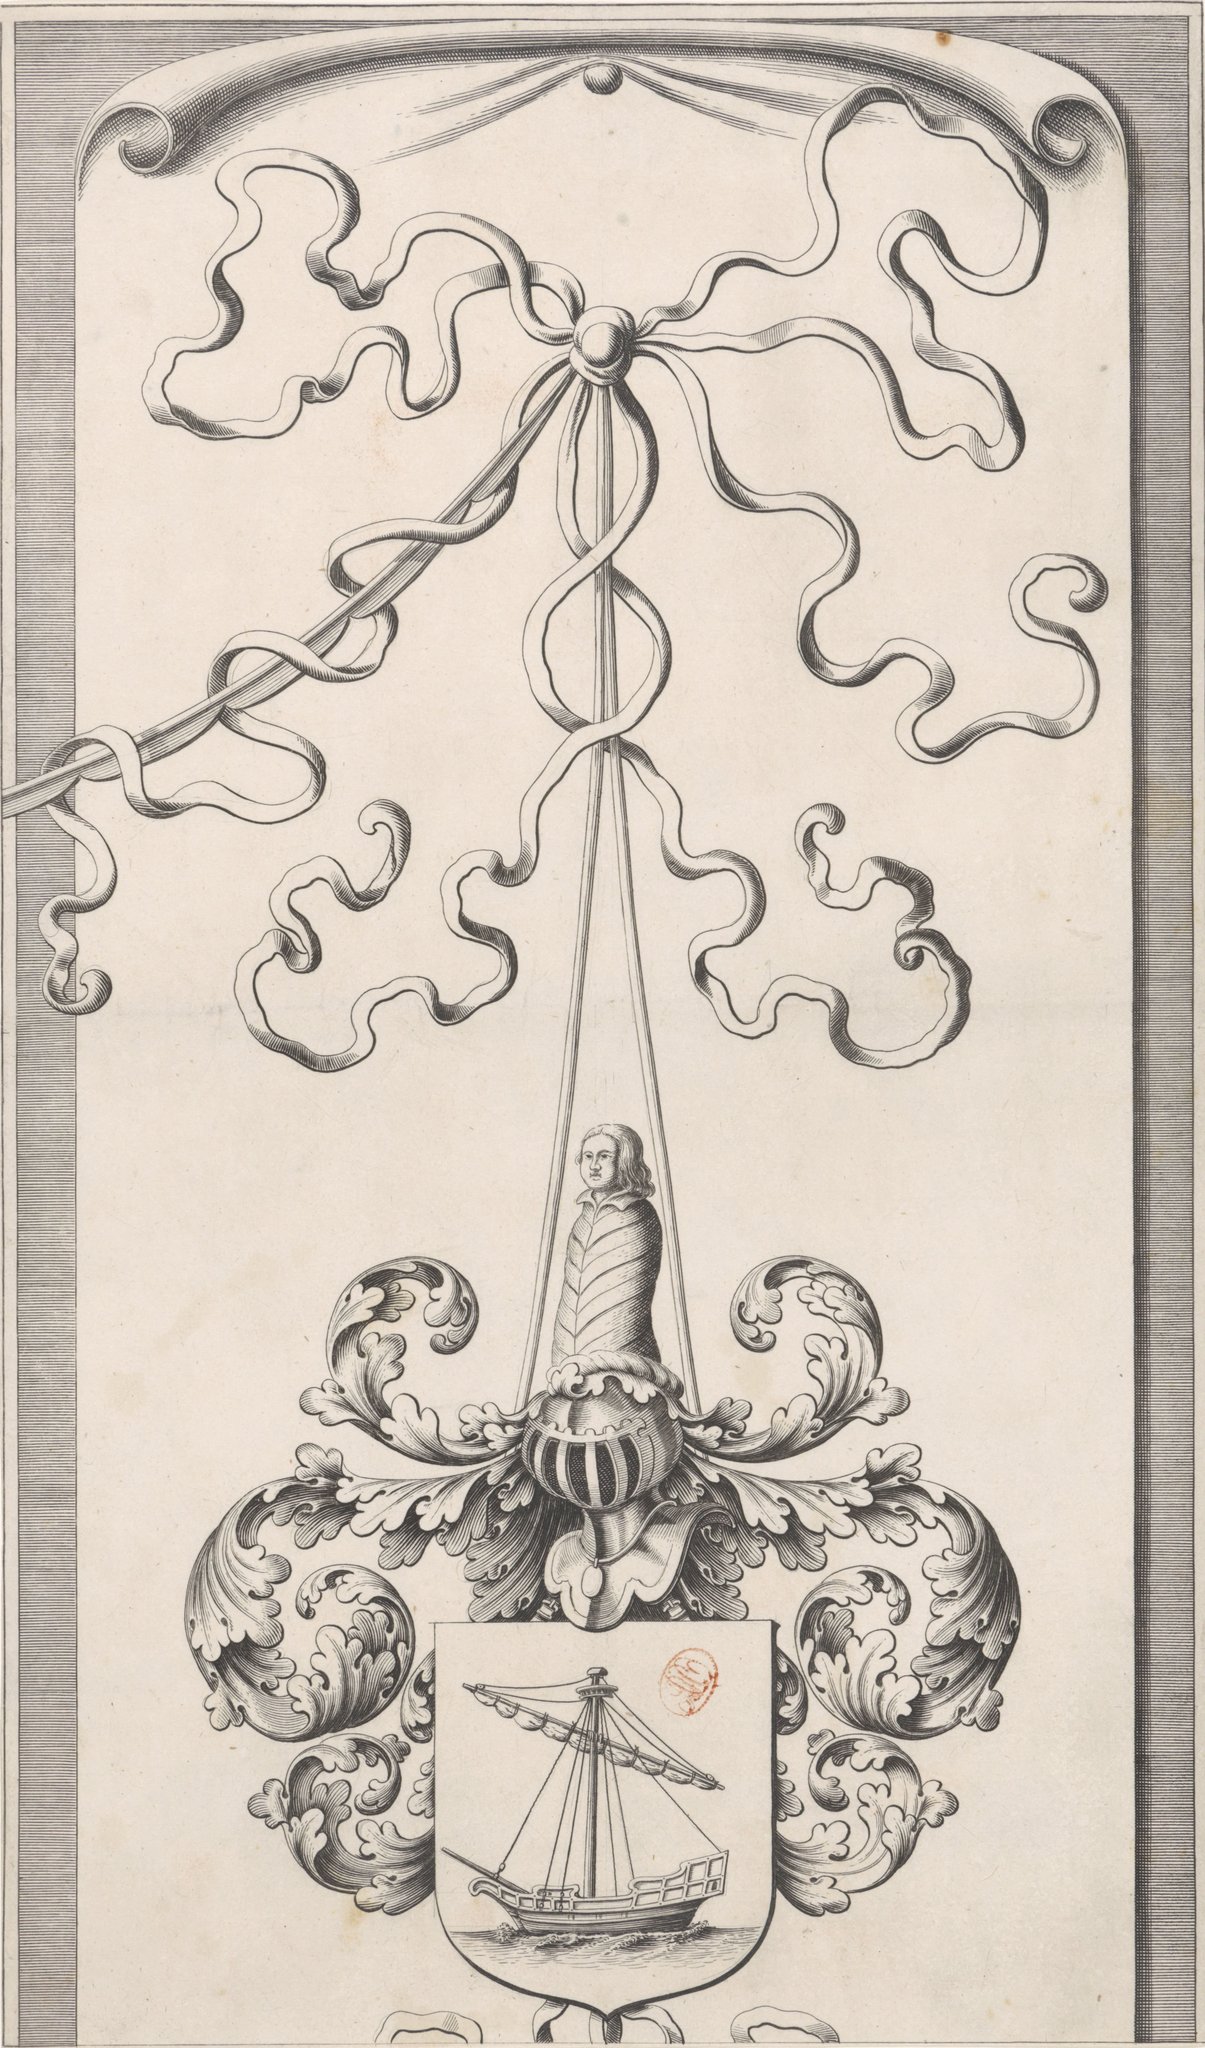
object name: print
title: Het Hooge Heemraedtschap van Schielandt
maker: johannes vinckboons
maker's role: draughtsman, print maker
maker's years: 1616-1670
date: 1660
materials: paper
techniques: engraving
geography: amsterdam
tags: mayor, armorial bearing, heraldry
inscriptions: collector's mark: Lugt 2228, collector's mark: Lugt 195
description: Deze prent is onderdeel van de linker wapenrand van de eerste druk (1660) van 'Het Hooge Heemraedtschap van Schielandt', een negendelige kaart van het hoogheemraadschap van Schieland. Van deze kaart zijn voor zover na te gaan zes verschillende drukken bekend, uit respectievelijk 1660, 1684, 1694, 1710, 1718 en 1765. Het hoogheemraadschap gaf in 1650 opdracht tot het maken van de kaart. De wapens van de toen zittende dijkgraaf, vijf hoogheemraden en rentmeester/secretaris staan daarom op de kaart, die echter pas in 1660 werd voltooid en voor het eerst uitgegeven. Slechts de dijkgraaf en één hoogheemraad zaten toen nog in het bestuur. Vermoedelijk werd daarom bij de eerste druk een wapenrand met de wapens en namen van de vier overige hoogheemraden en de rentmeester/secretaris en een schild met alle namen van de dijkgraaf en hoogheemraden uit 1650 en 1660 toegevoegd. De huidige prent is onderdeel van de wapenrand van deze eerste druk. Voor de tweede druk van de kaart werd slechts één plaat bijgewerkt. Verondersteld wordt dat vervolgens voor de derde, vierde en vijfde druk de platen onveranderd bleven. Wel werd voor iedere uitgave een nieuwe wapenrand gedrukt met de wapens en namen van de toen zittende bestuursleden van het hoogheemraadschap. In 1765 werden de platen van de kaart, op één na, allen bijgewerkt. Voor de rechter wapenrand, zie RP-P-AO-13-3Z. Voor een exemplaar van de tweede (1684), derde (1694), vierde (1710) of vijfde (1718) druk van de kaart, zie RP-P-AO-13-3X.